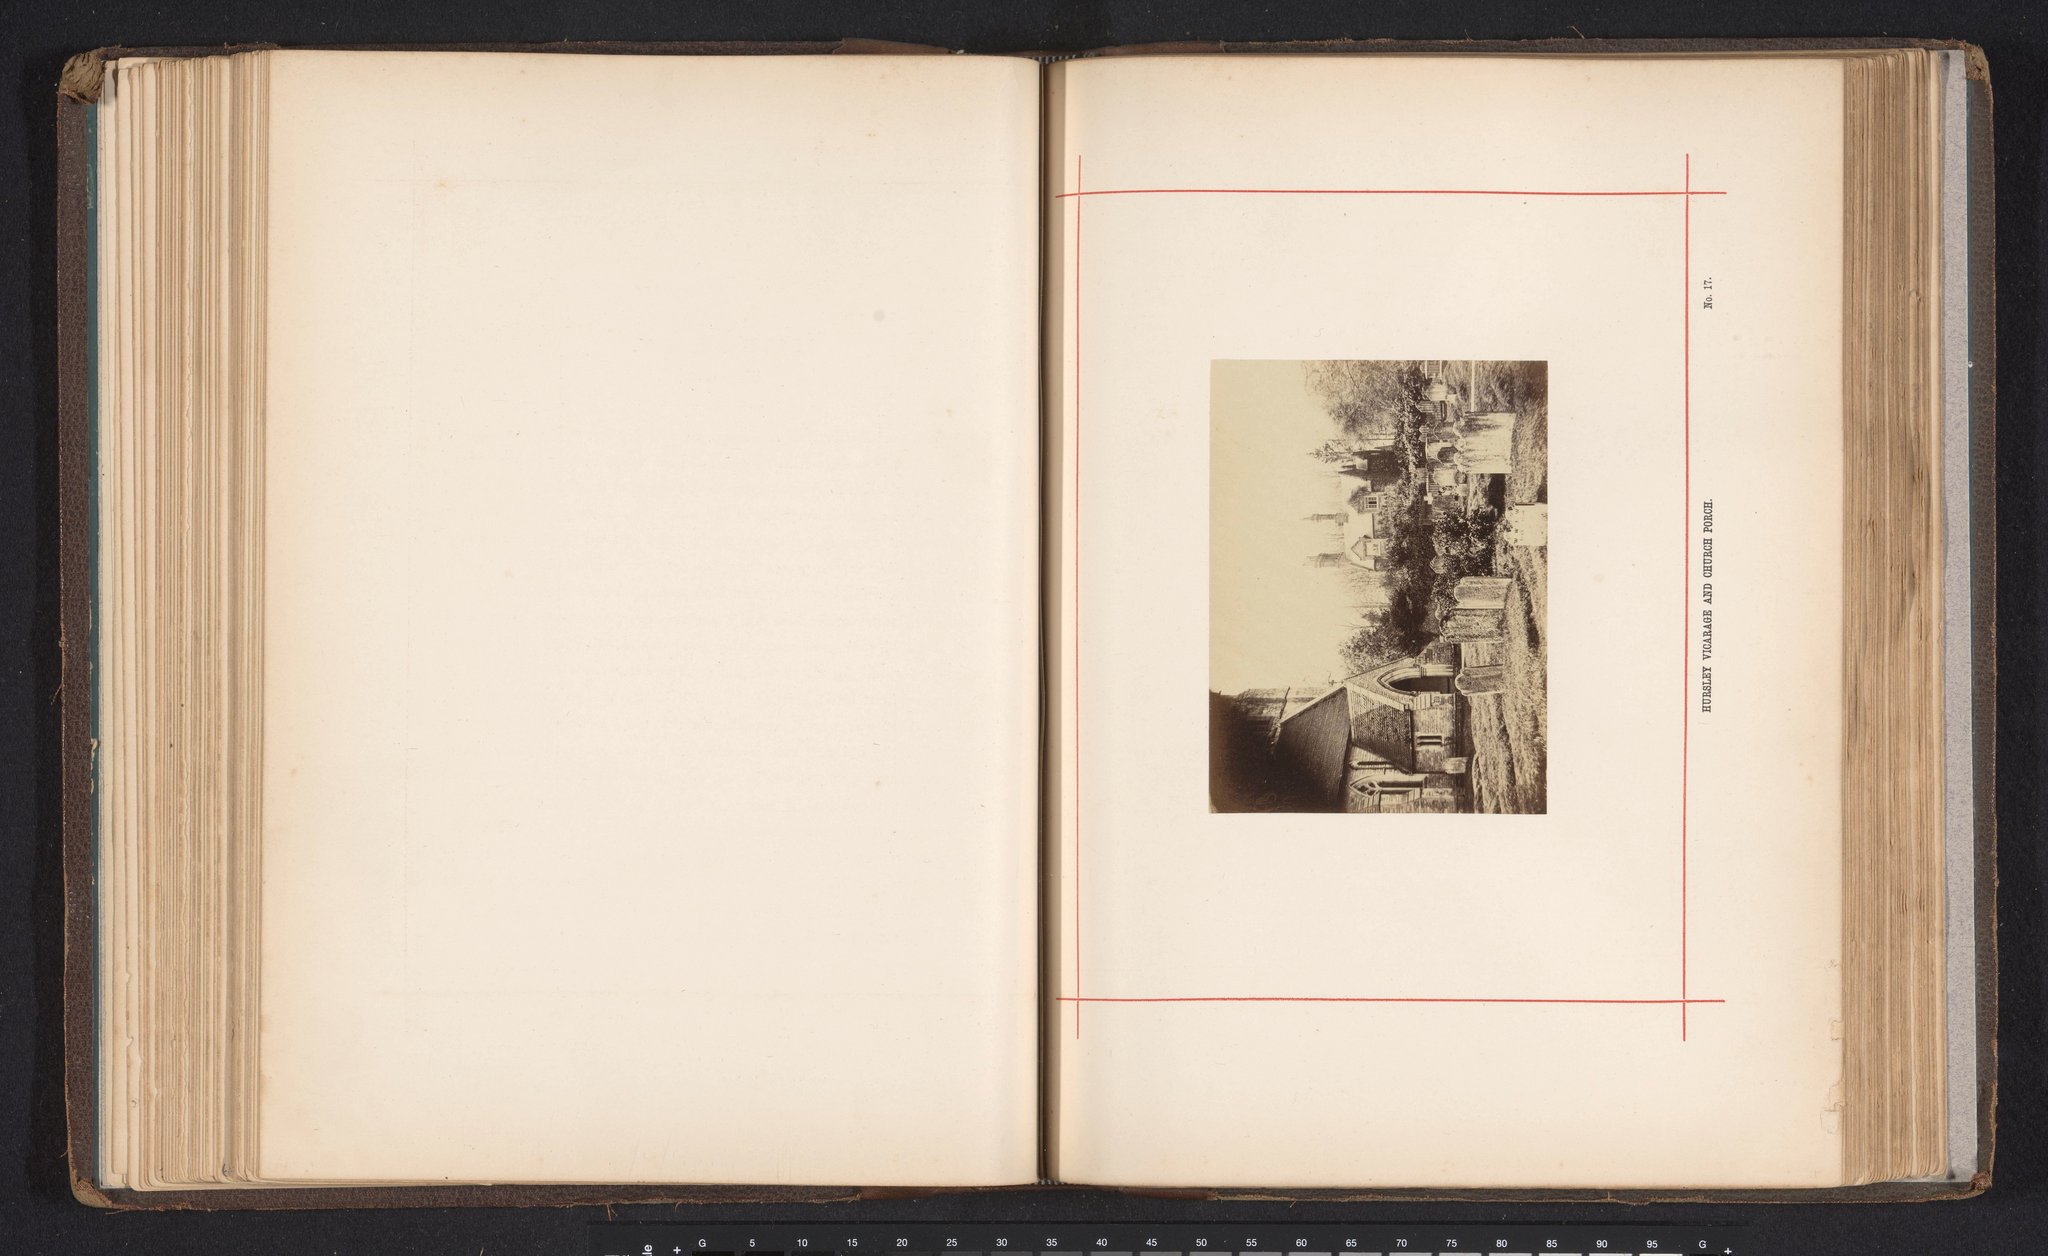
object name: photograph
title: Hursley Vicarage and Church Porch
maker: william savage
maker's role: fotograaf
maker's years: 1817-1887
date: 1861-1866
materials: paper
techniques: albumen print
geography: hursley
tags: churchyard, cemetery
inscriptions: number: ‘No. 17.’